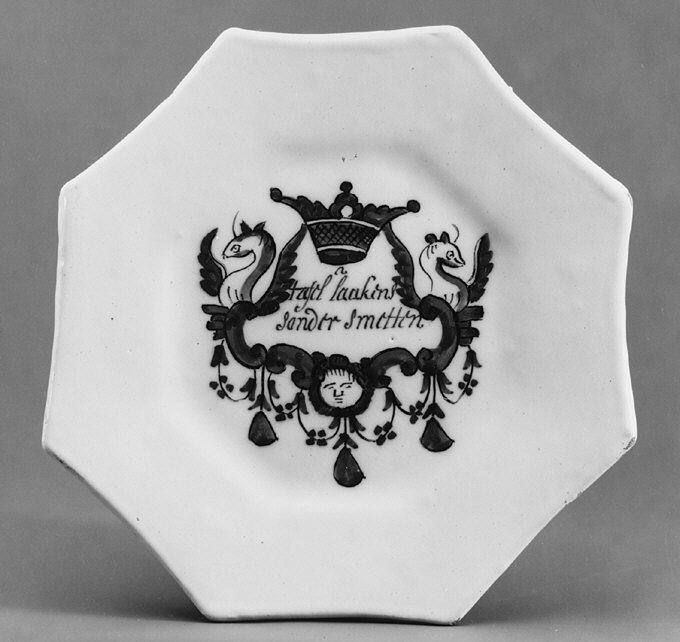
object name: plate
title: Plate (part of a set)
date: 1660-1690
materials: earthenware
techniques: glazing